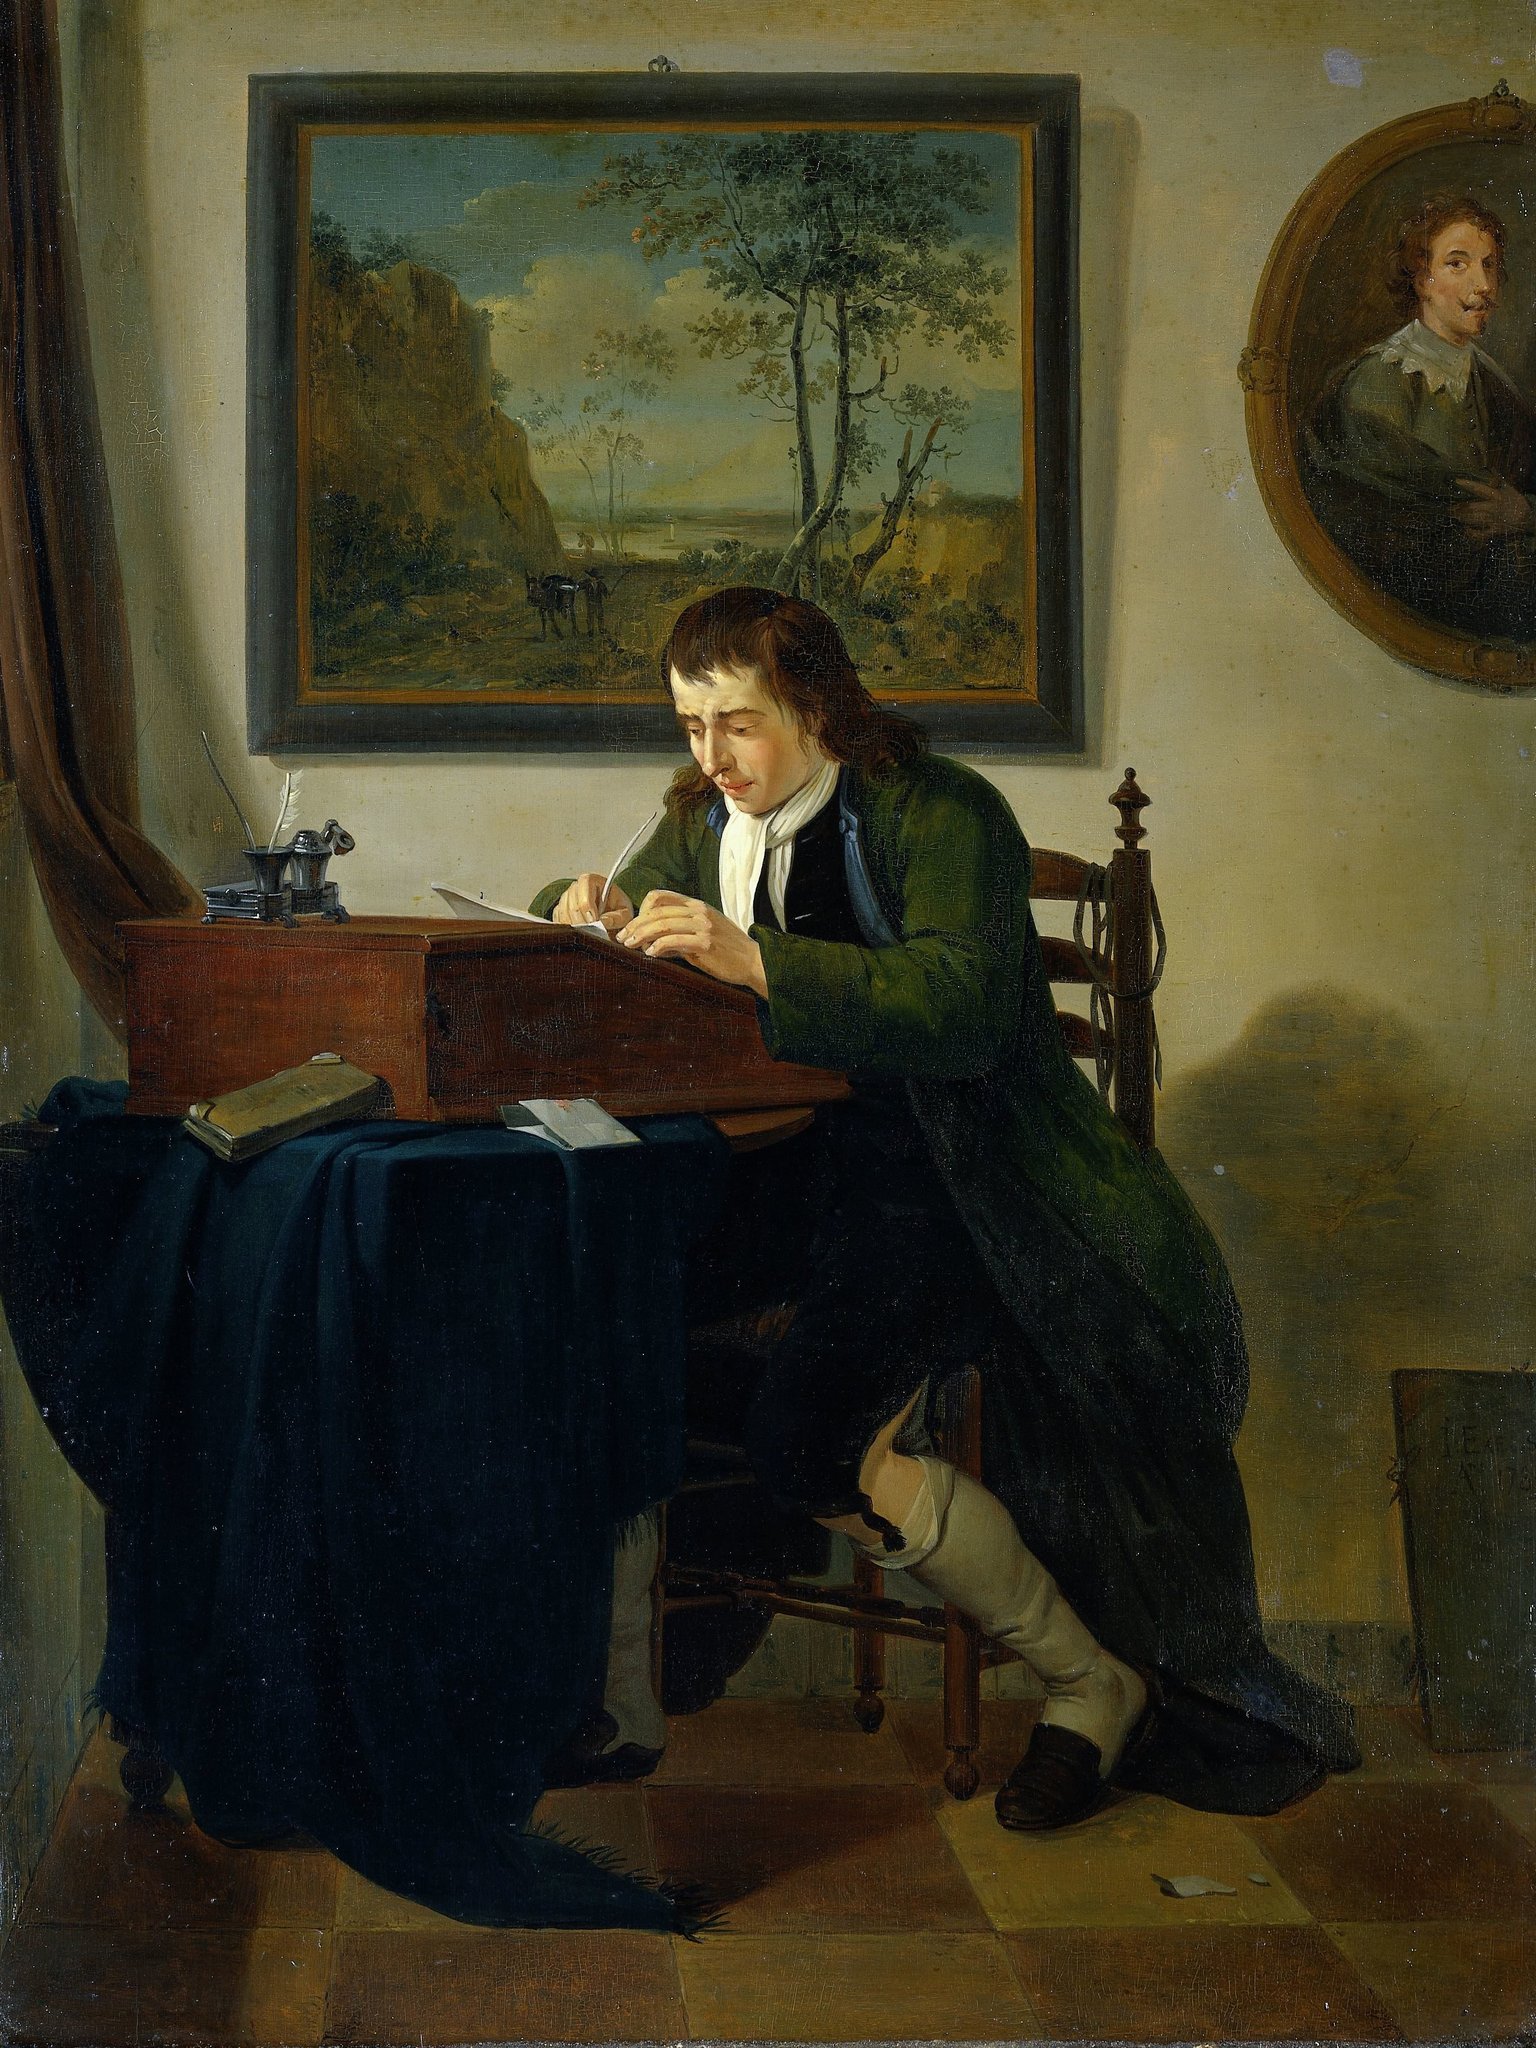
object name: painting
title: A Man Writing at his Desk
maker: jan ekels (ii)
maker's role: draughtsman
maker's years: 1759-1793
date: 1784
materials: oil, panel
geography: northern netherlands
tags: writing-table, writing-desk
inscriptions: signature and date: ‘I. Ekels A.no 1784’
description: Interieur met een man schrijvend aan een lessenaar op een tafel. Aan de muur hangen twee schilderijen: een landschap en een mansportret.